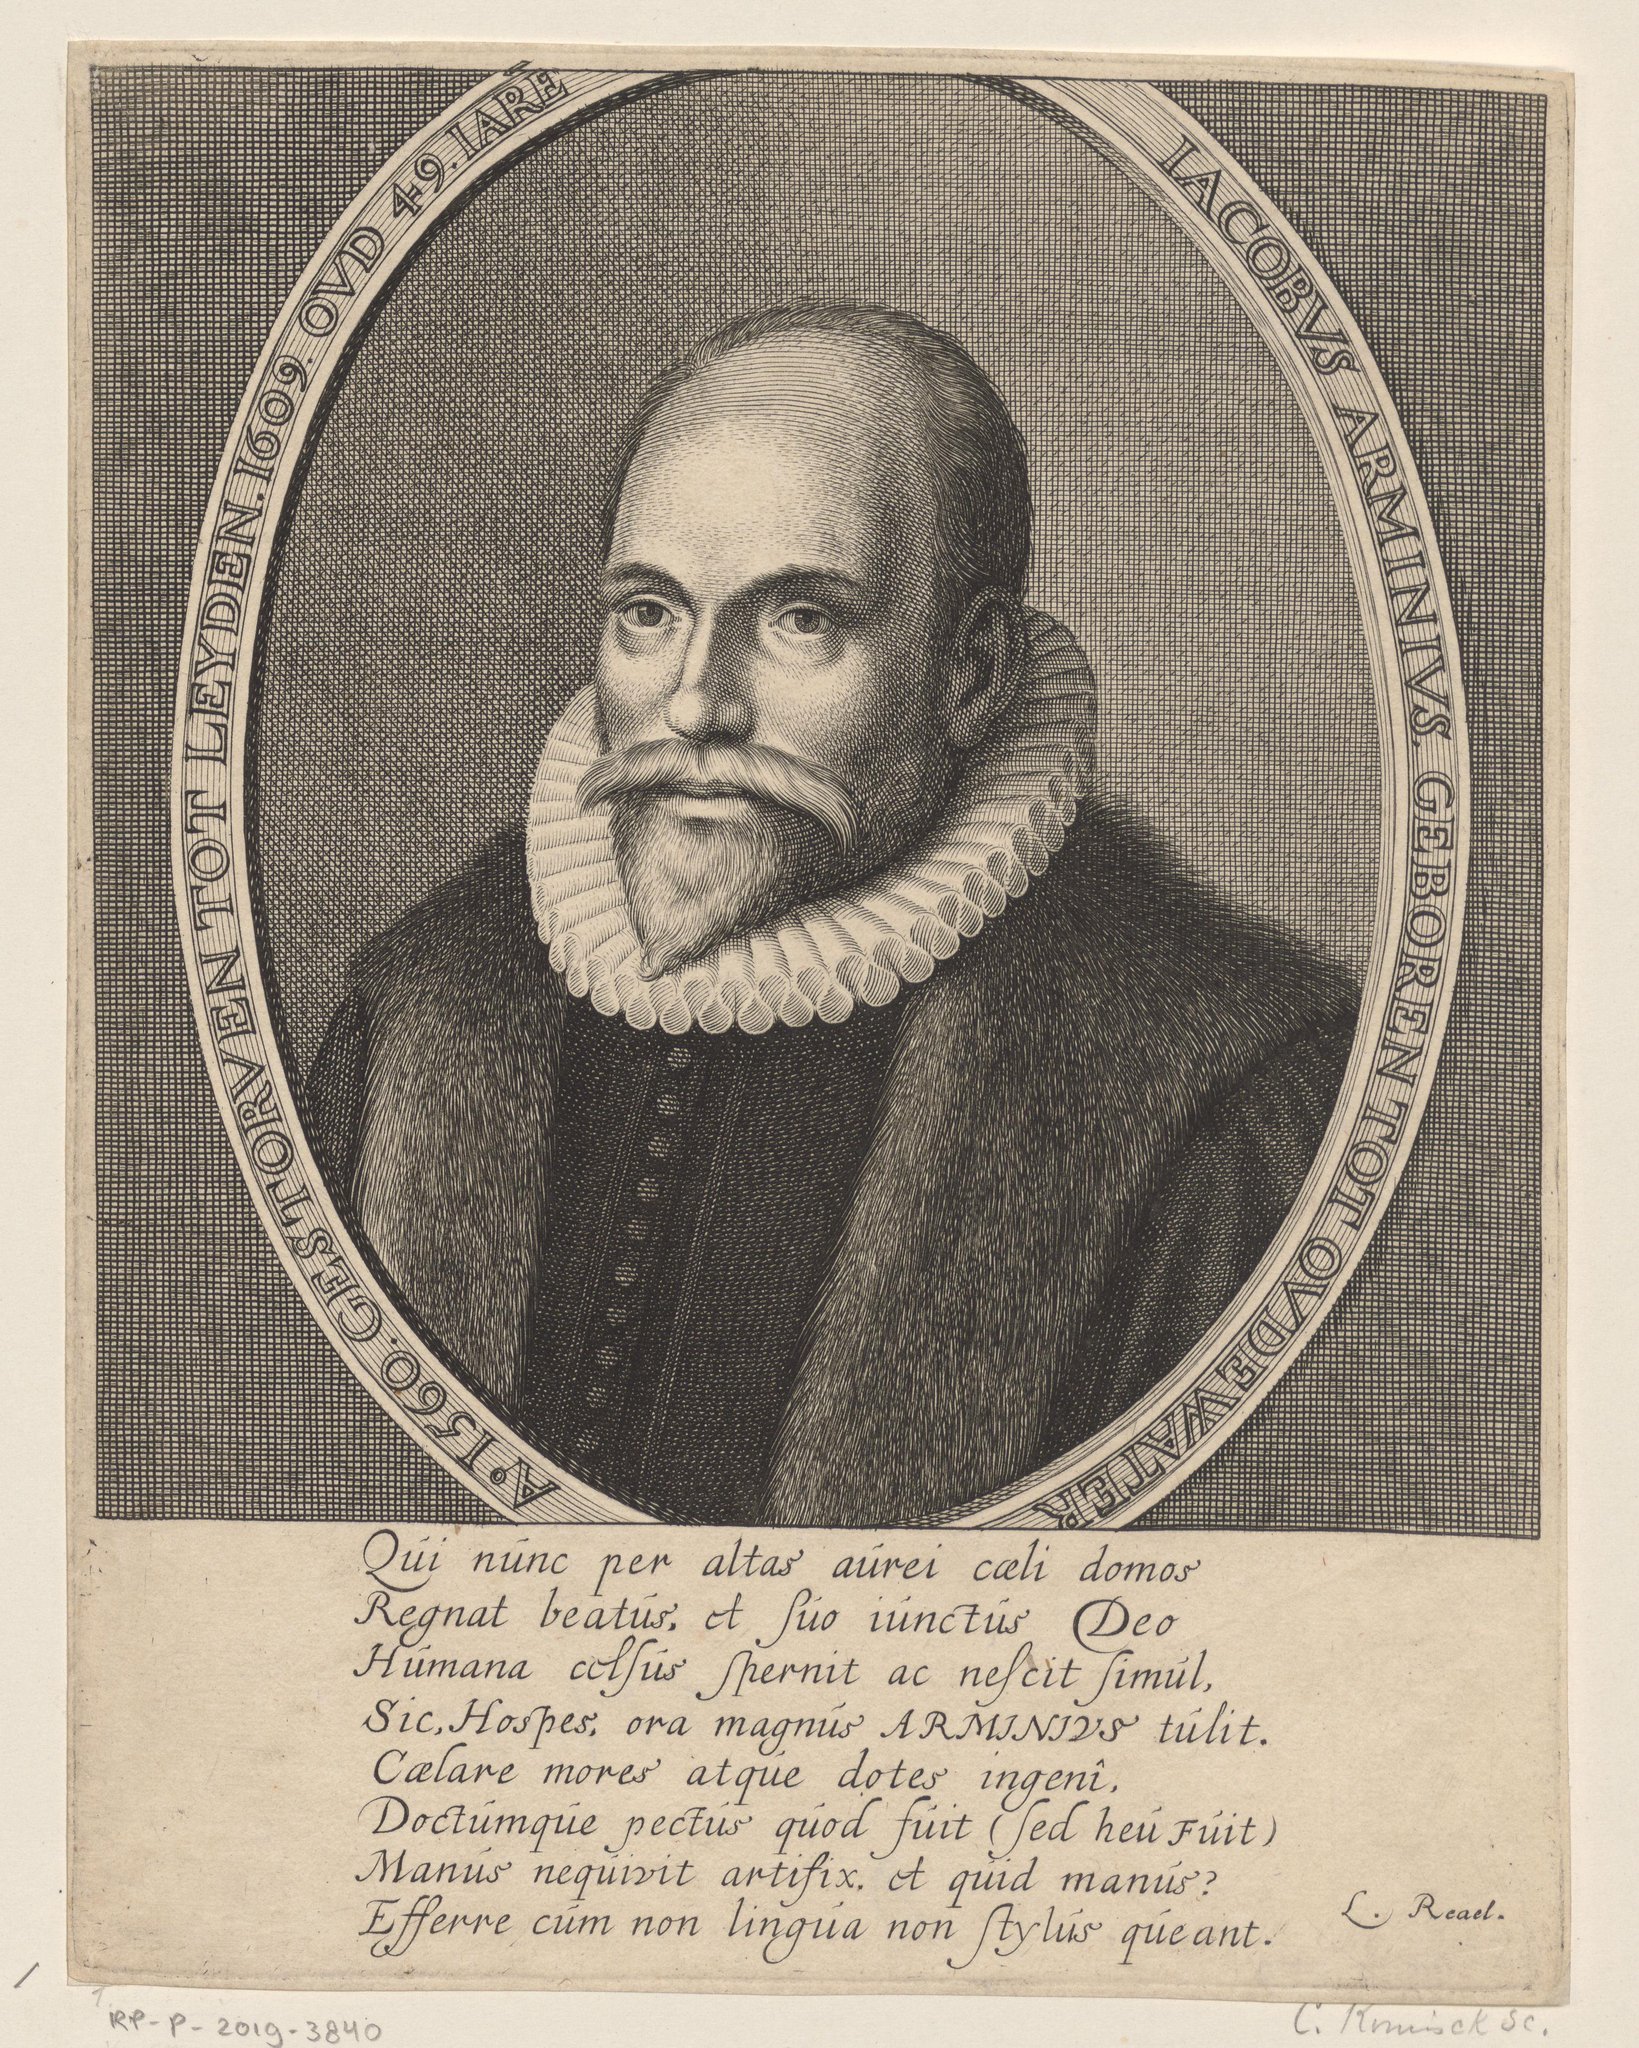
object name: print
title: Portret van Jacobus Arminius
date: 1608-1671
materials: paper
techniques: engraving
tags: leiden, historical persons